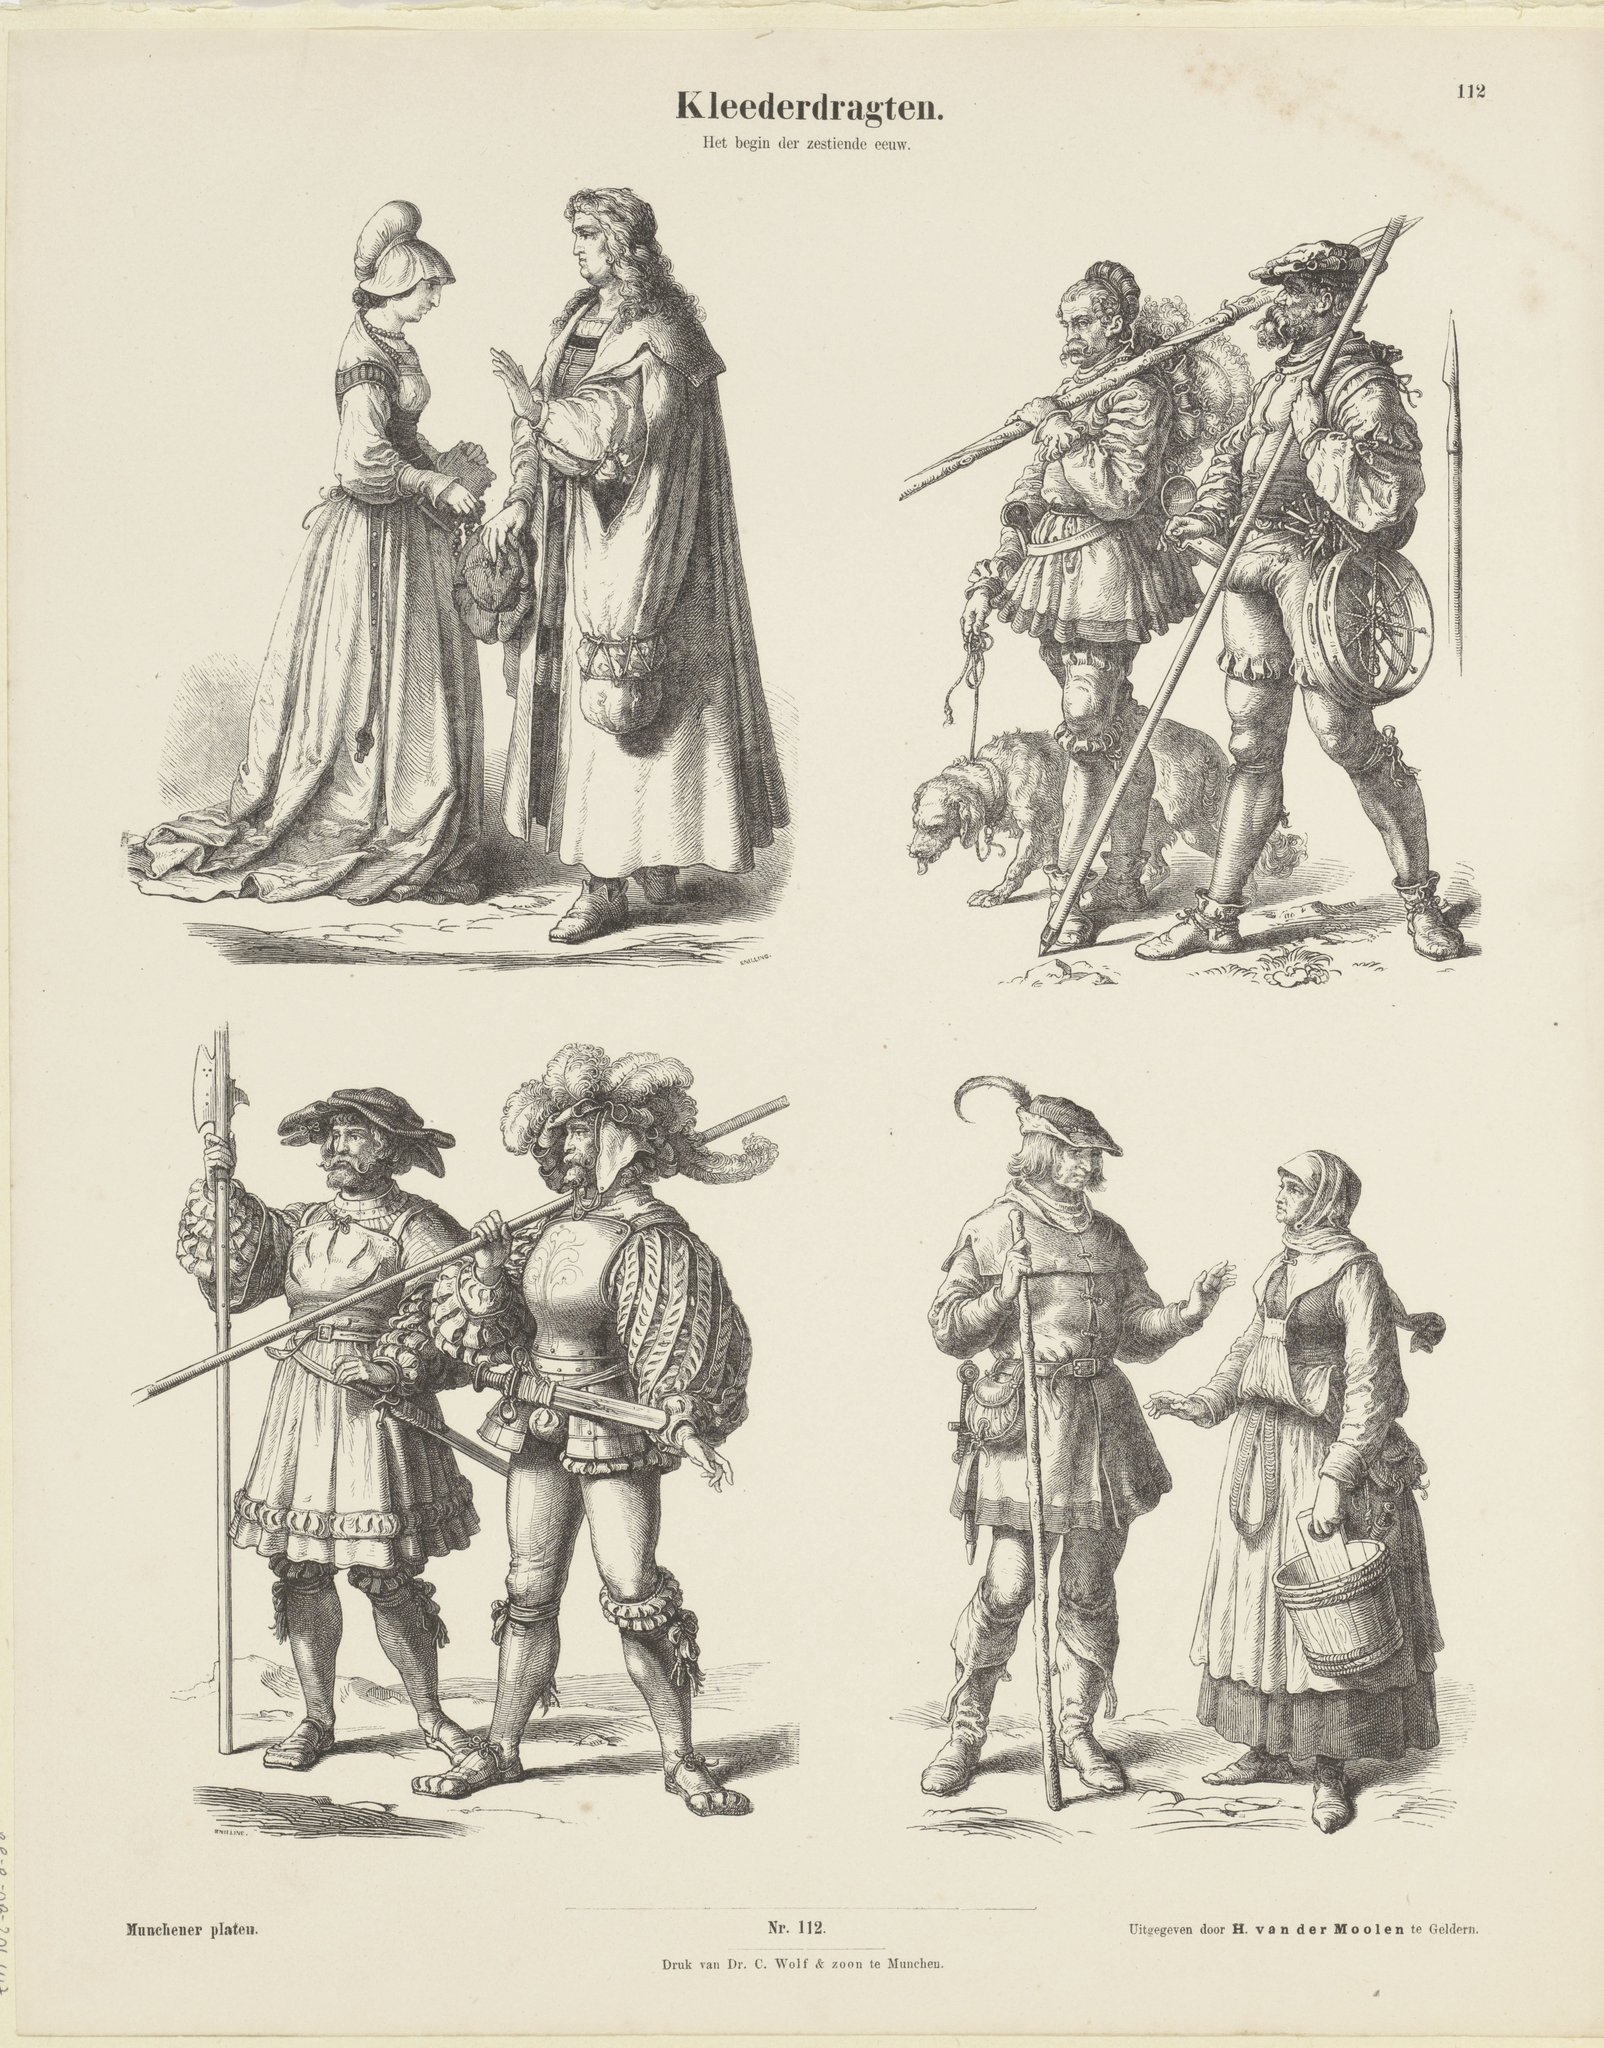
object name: print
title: Munchener platen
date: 1843-1920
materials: paper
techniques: letterpress printing, engraving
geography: munich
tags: historical costume, folk costume, regional costume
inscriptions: collector's mark: Lugt 2760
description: Nederlandse editie van een prent uit de reeks "Munchener platen" uitgegeven door K. Braun & Fr. Schneider te München met het adres van wederverkoper Hermann van der Moolen.